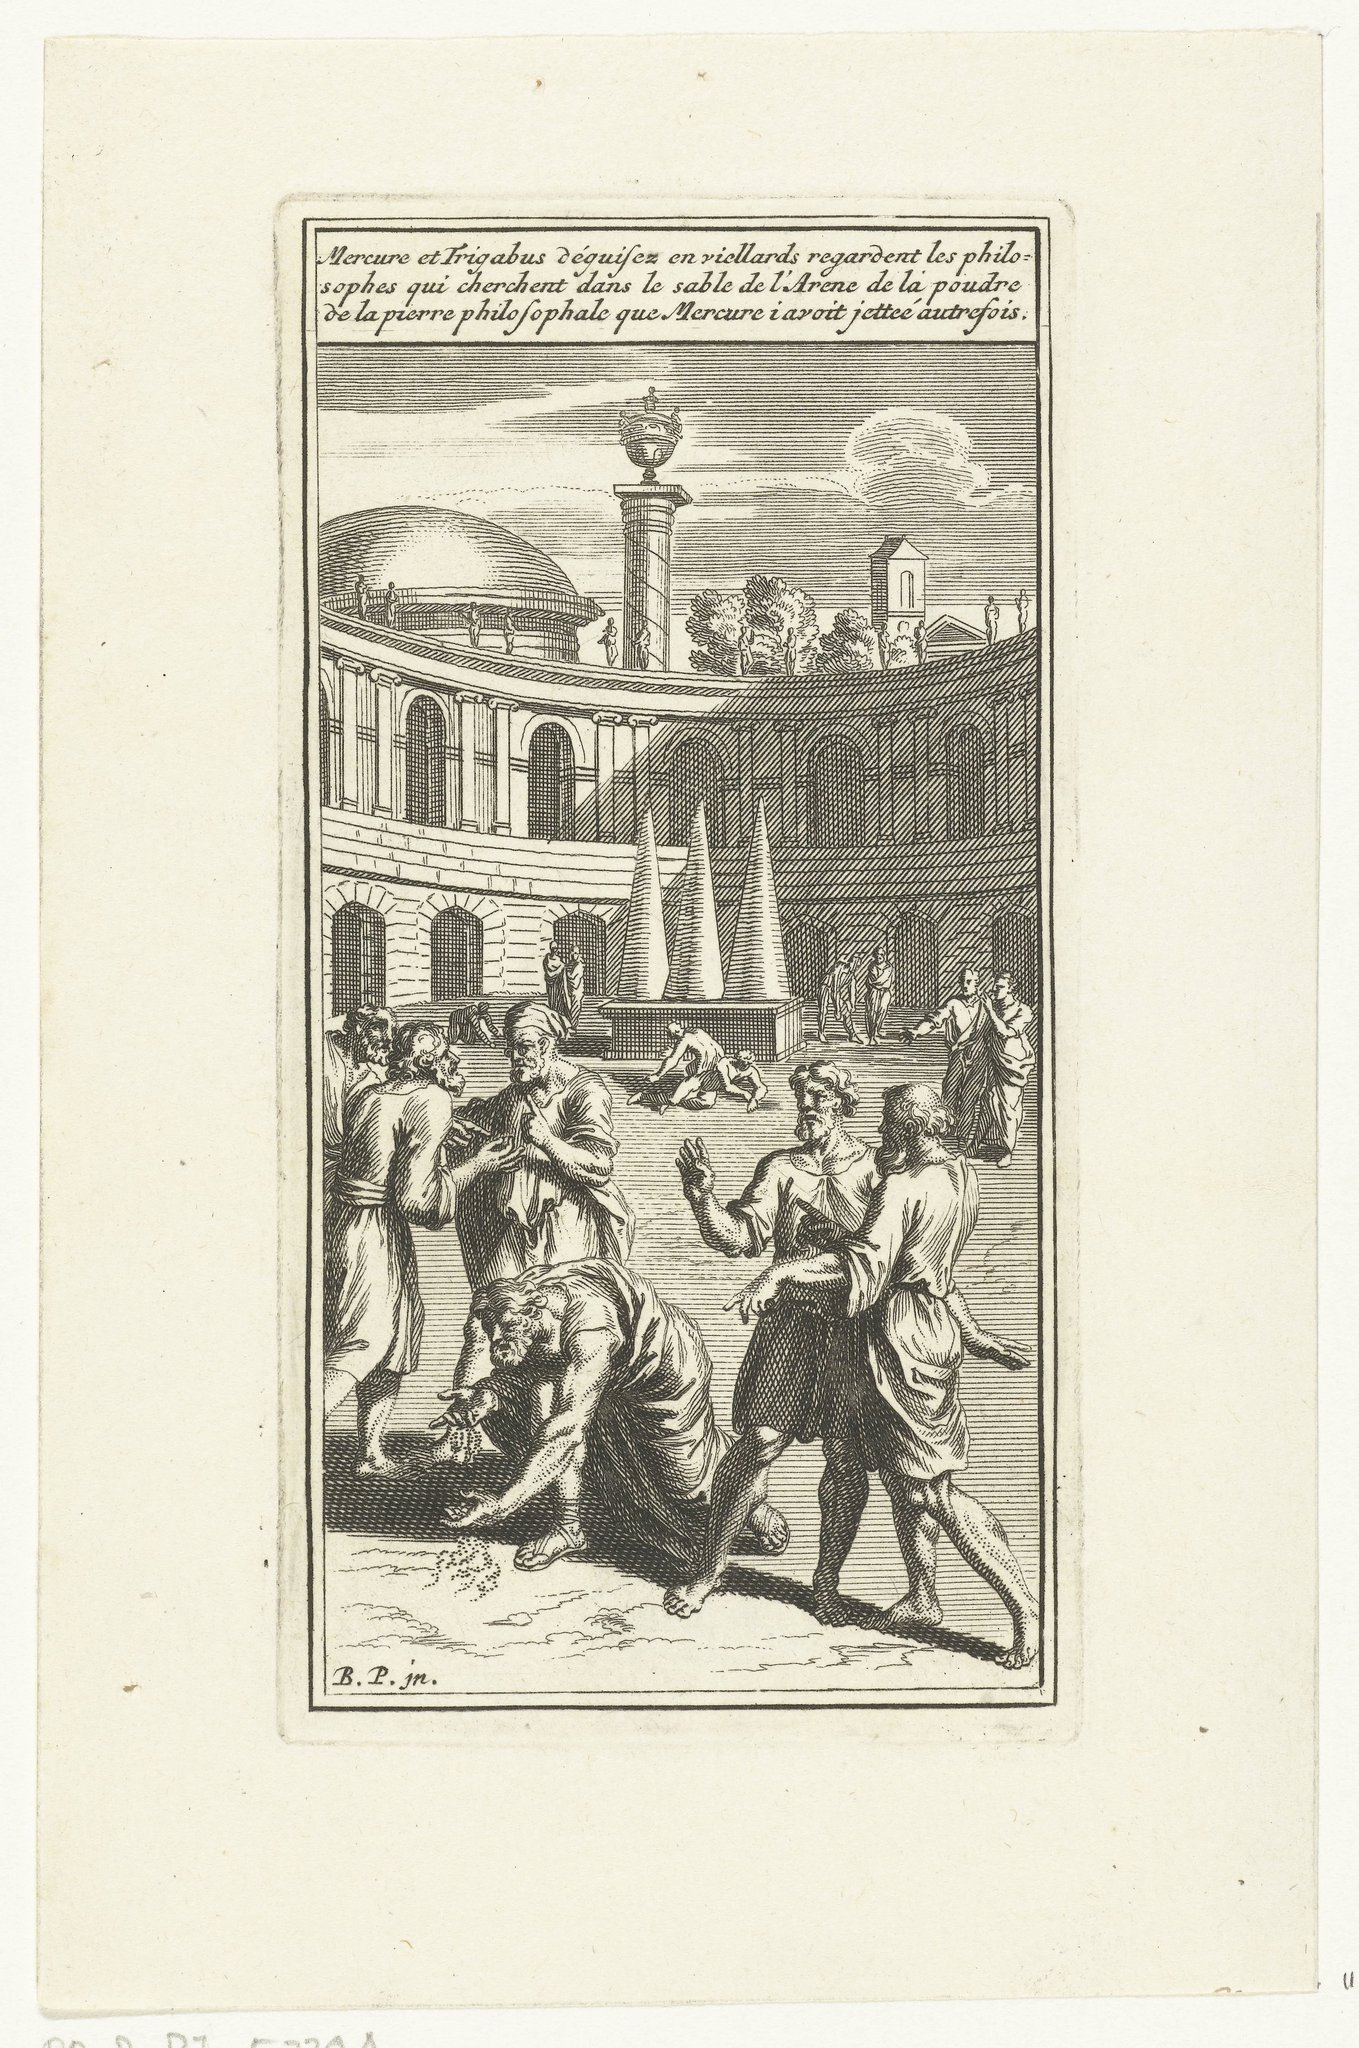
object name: book illustration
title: Filosofen zoeken in het zand van de arena naar het poeder van de steen der wijzen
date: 1700-1750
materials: paper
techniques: etching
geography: amsterdam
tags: wisdom, 'sapientia' ~ one of the seven gifts of the soul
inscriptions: collector's mark: Lugt 2228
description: Illustratie voor: Bonaventure Des Perriers, Jean. Cymbalum mundi, ou Dialogues satyriques sur differens sujets. Amsterdam P. Marchand, 1711. Ook in latere edities van hetzelfde werk gebruikt.